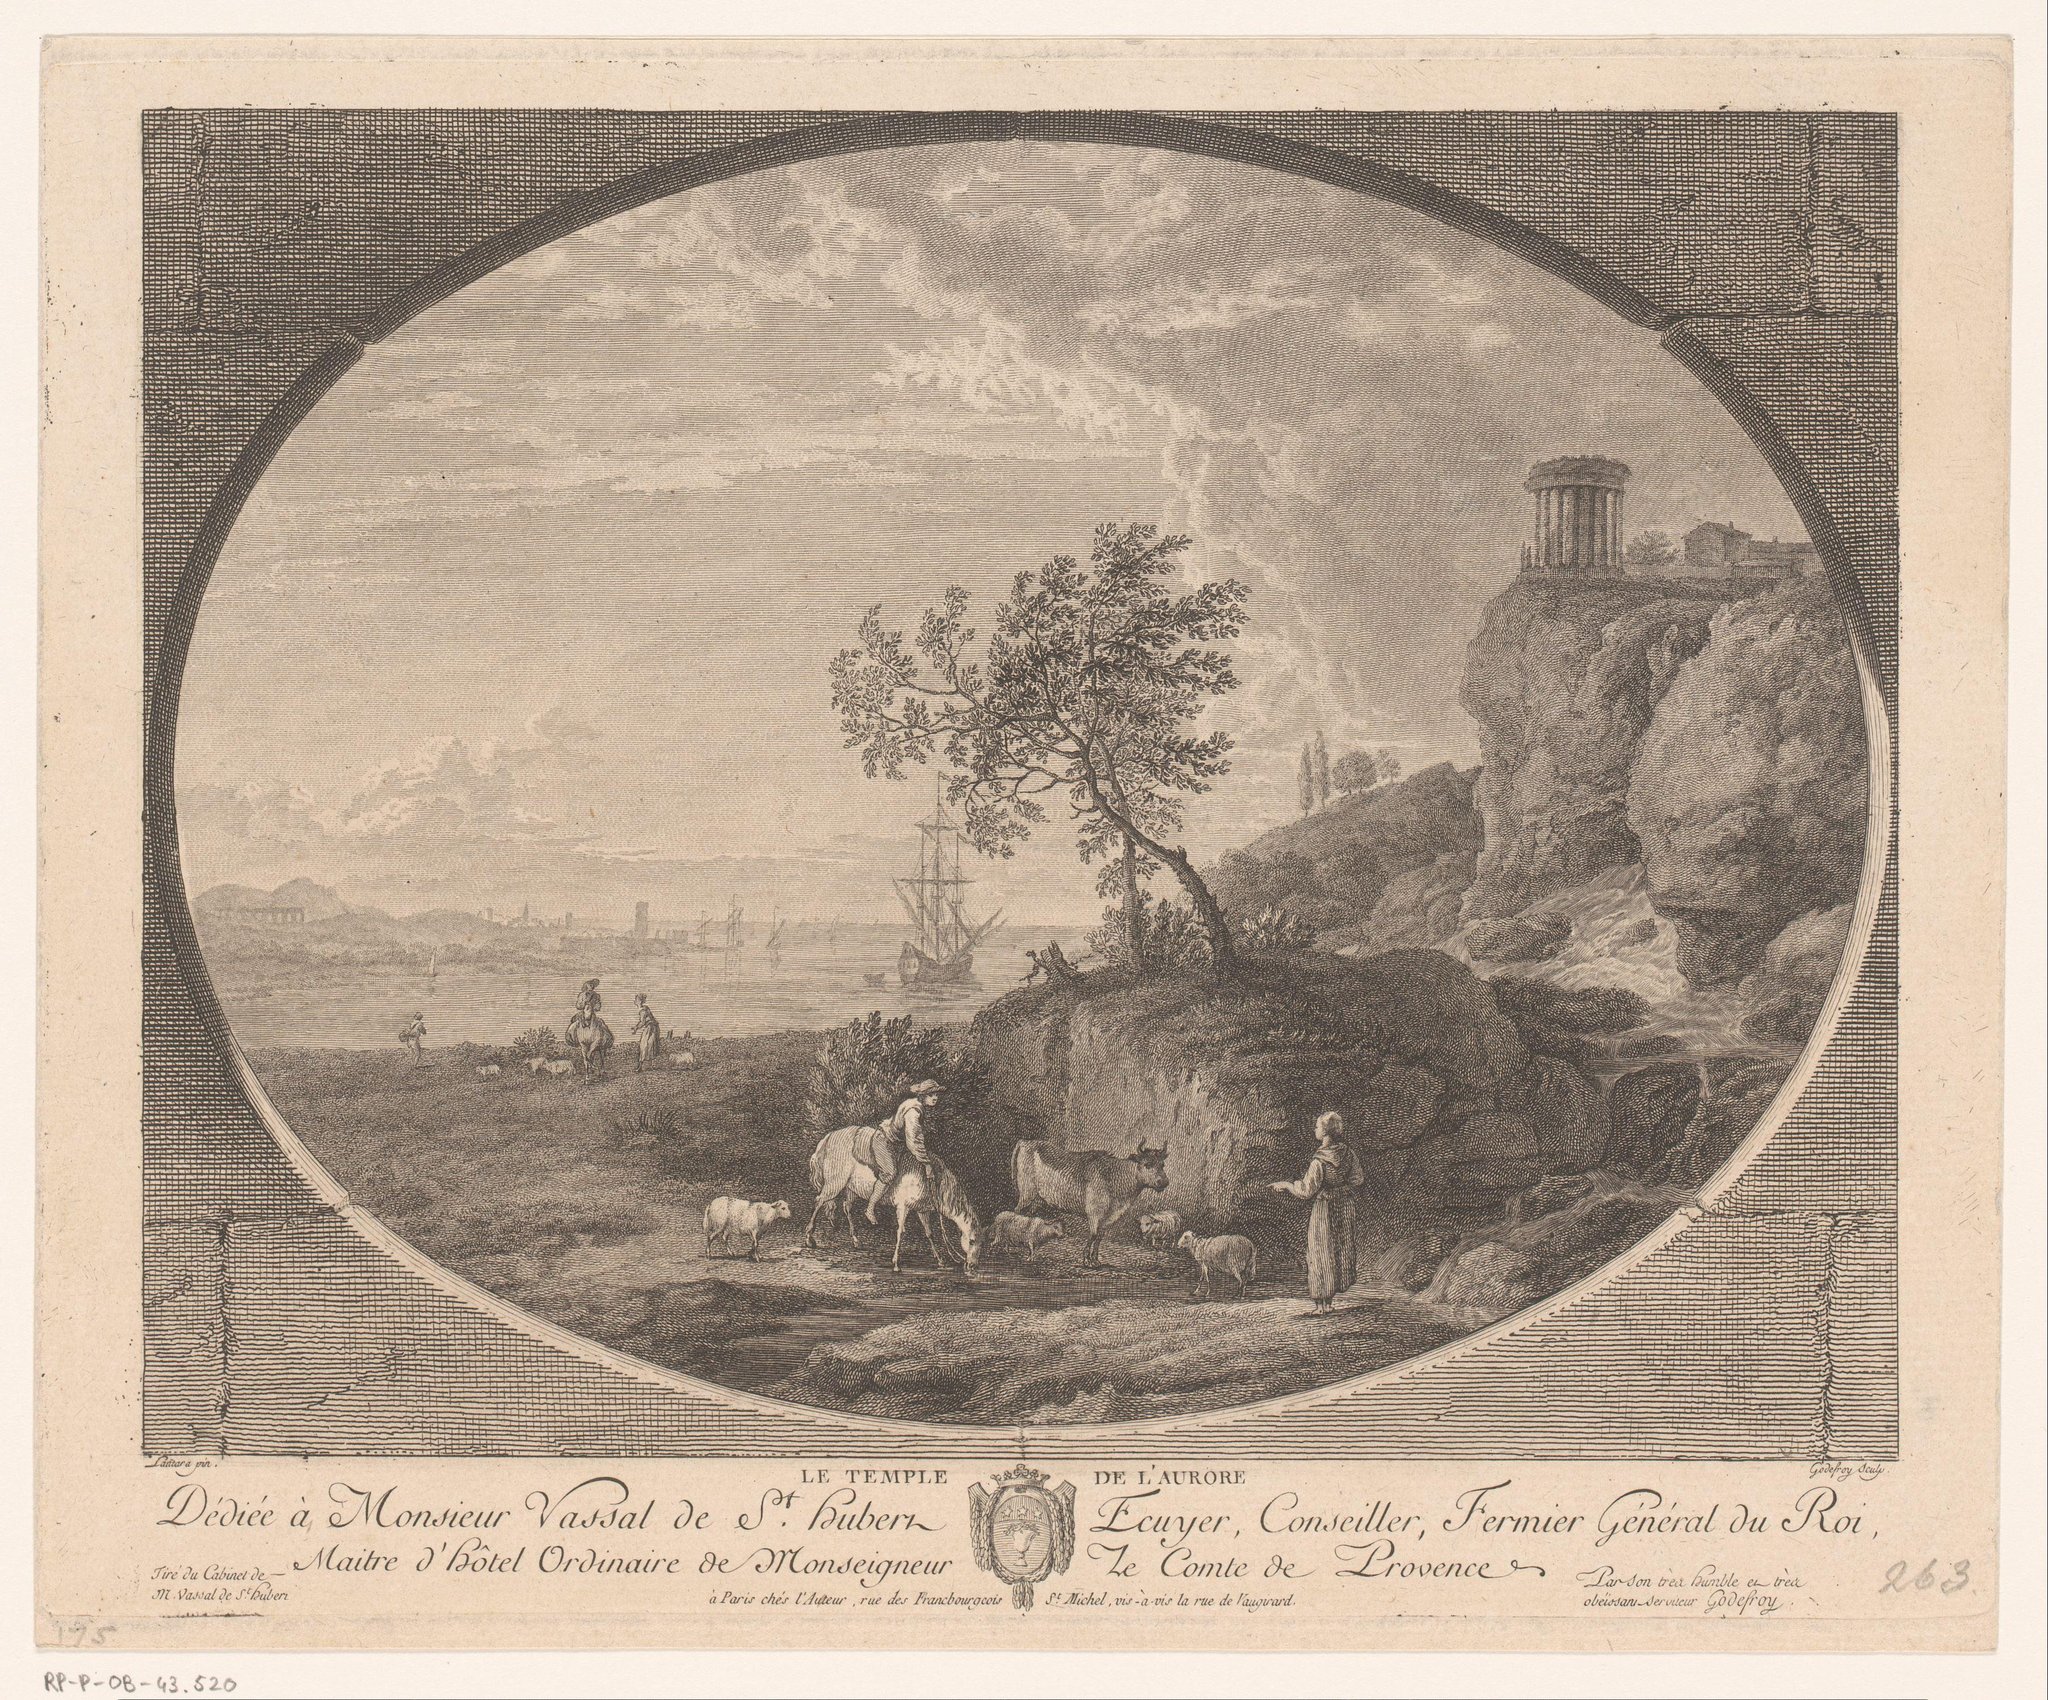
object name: print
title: Kustlandschap met figuren voor de Tempel van Aurora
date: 1753-1819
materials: paper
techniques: etching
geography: france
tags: herding, herdsman, herdswoman, shepherd, shepherdess, cowherd, etc., temple, shrine ~ roman religion, coast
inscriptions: collector's mark: Lugt 2228